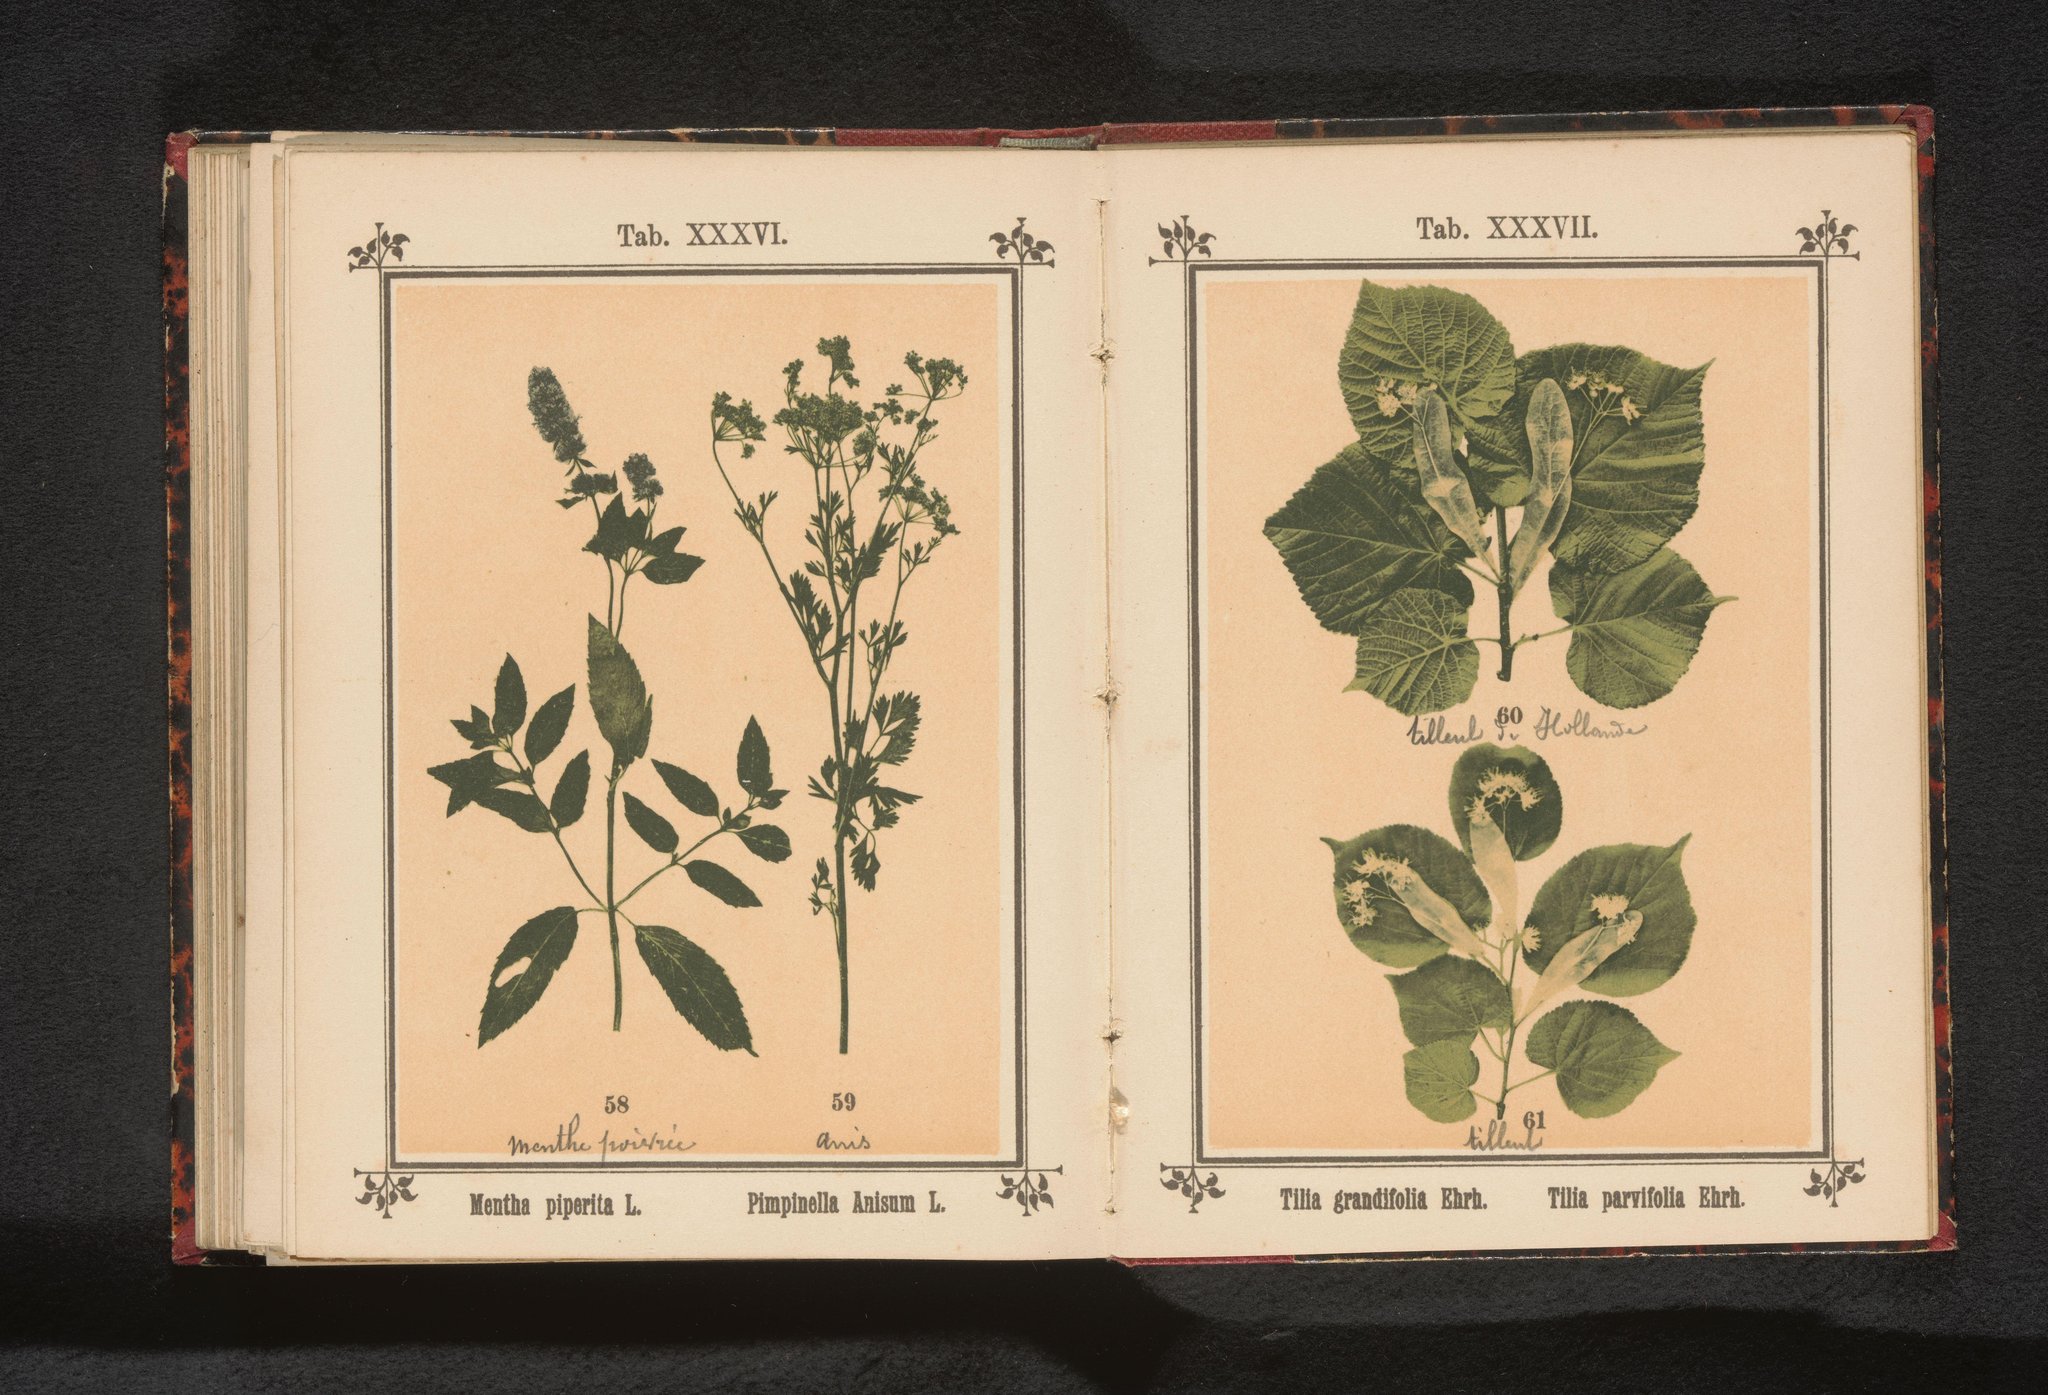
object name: page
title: Tak van een zomerlinde en een tak van een winterlinde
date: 1884-1894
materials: paper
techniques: photograph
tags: trees: linden (+ branch, stick)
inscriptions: number: ‘Tab. XXXVII.’, inscription: ‘tilleul Hollande tilleul’